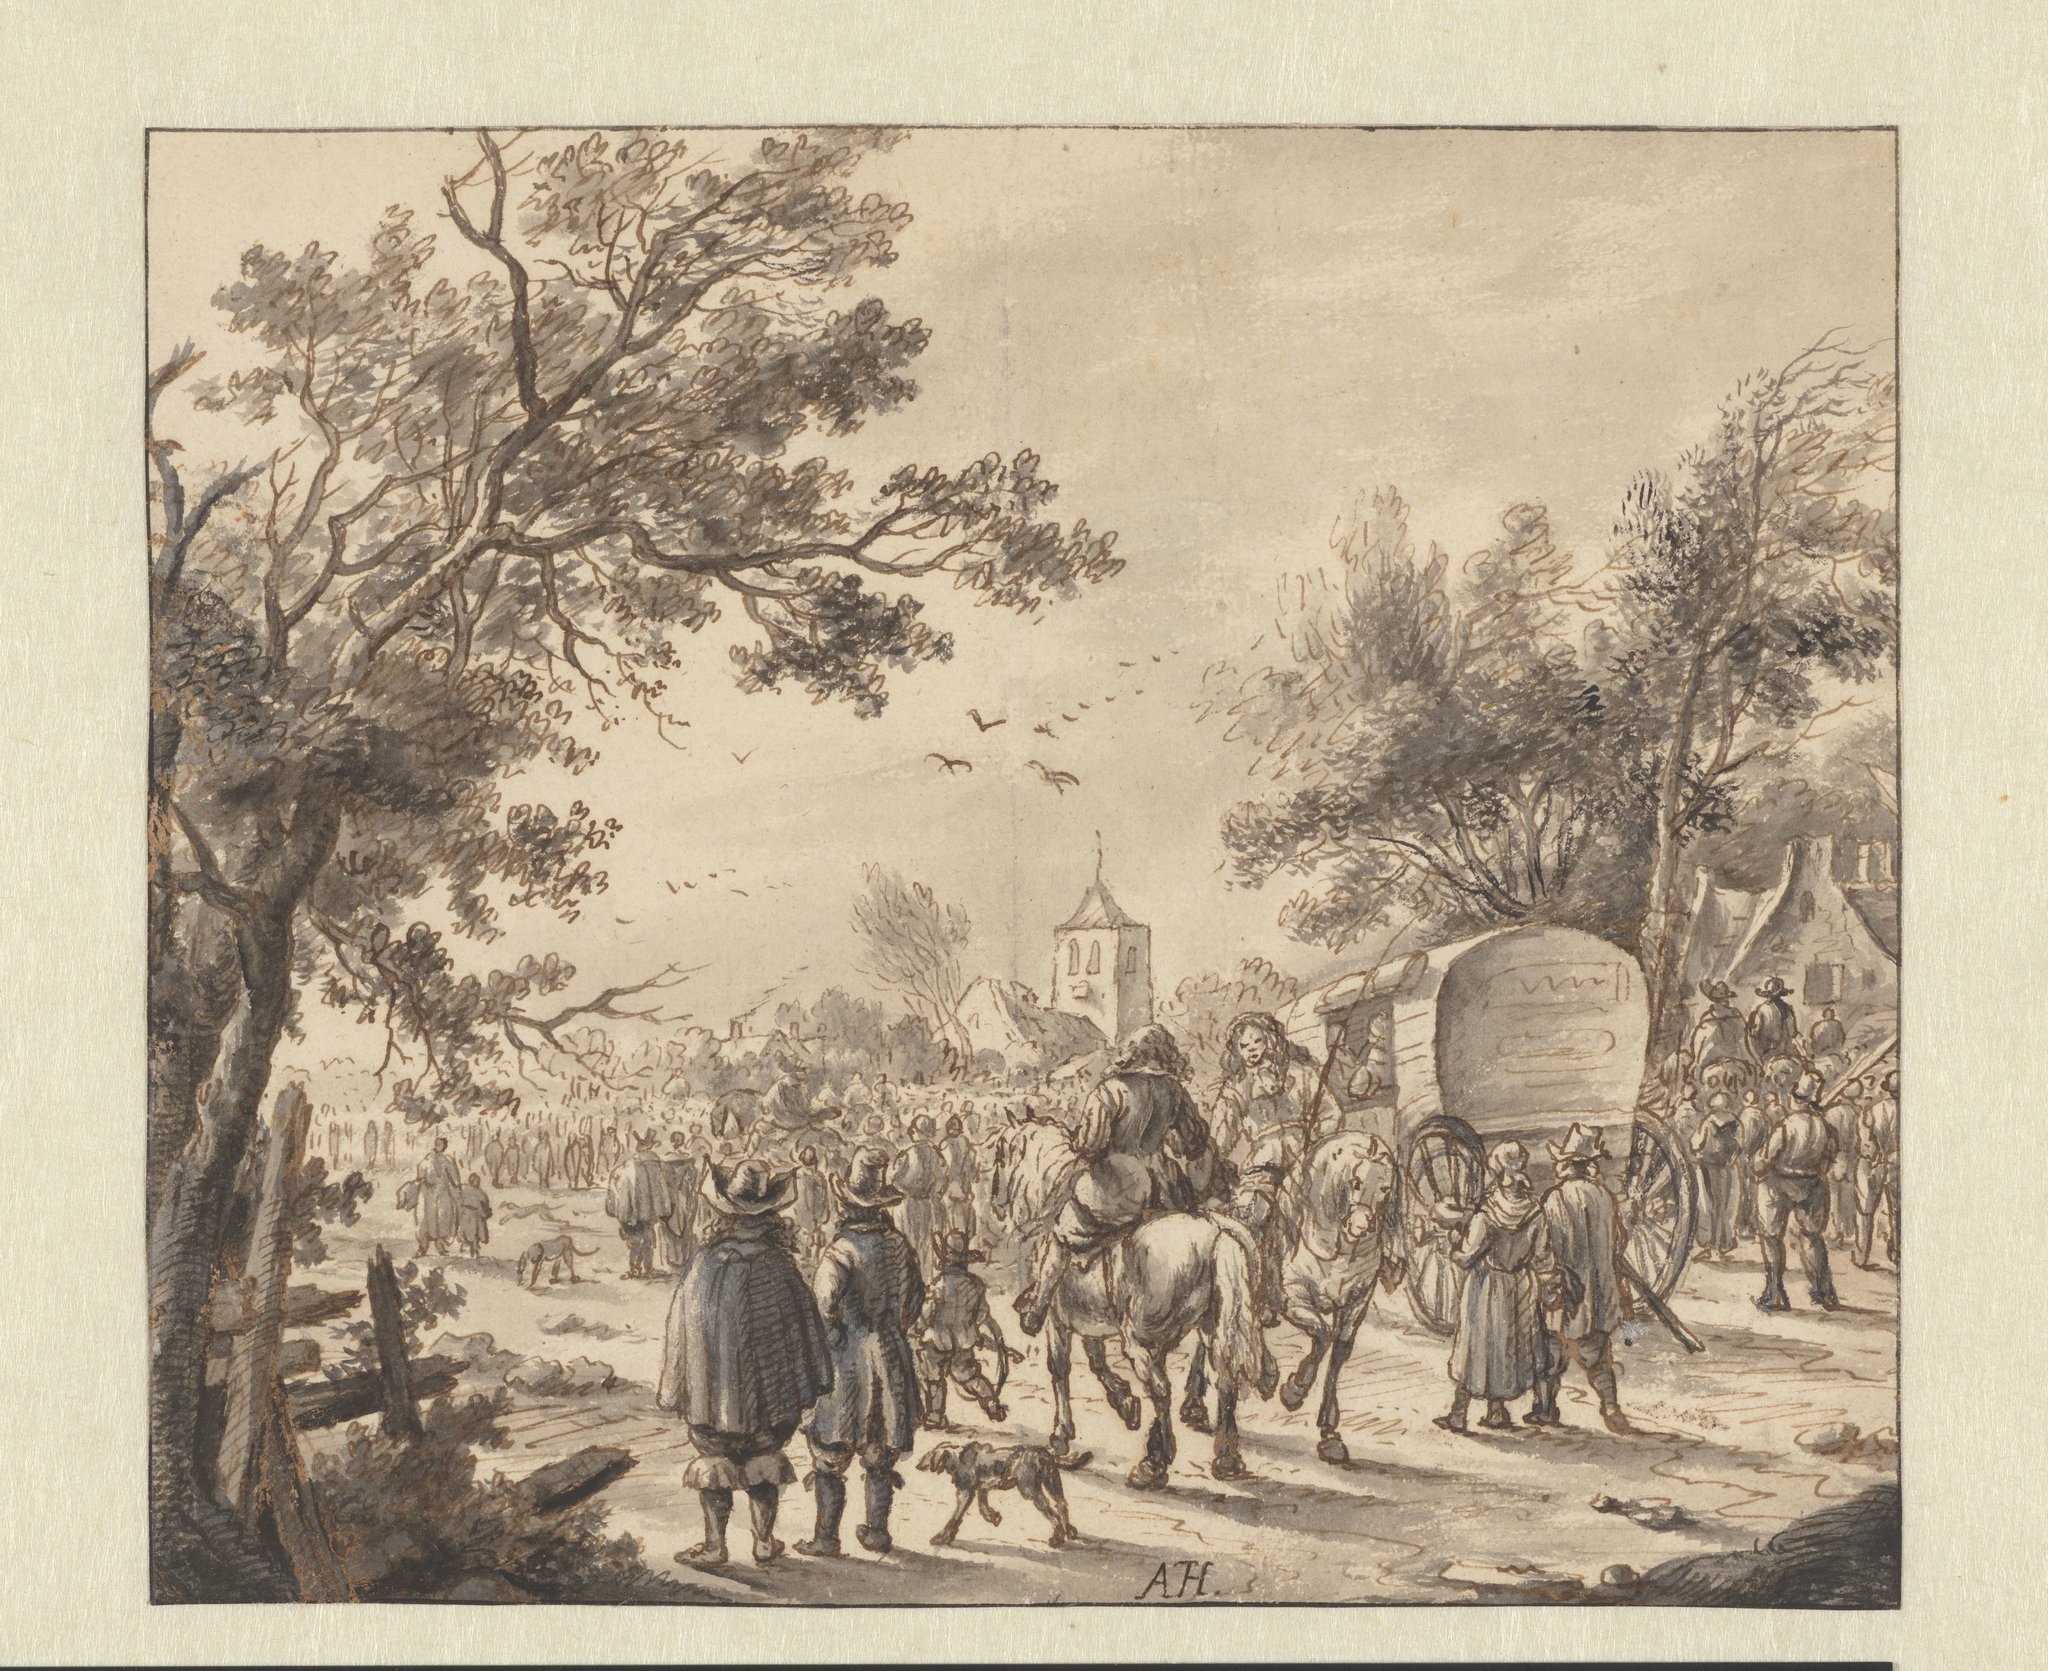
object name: drawing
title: Grote menigte verzameld bij een dorp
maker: aarnout ter himpel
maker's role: draughtsman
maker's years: 1634-1686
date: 1644-1686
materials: ink, paper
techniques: brush, pen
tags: animal traction, animal-drawn vehicle (carriage etc.), crowd, mob